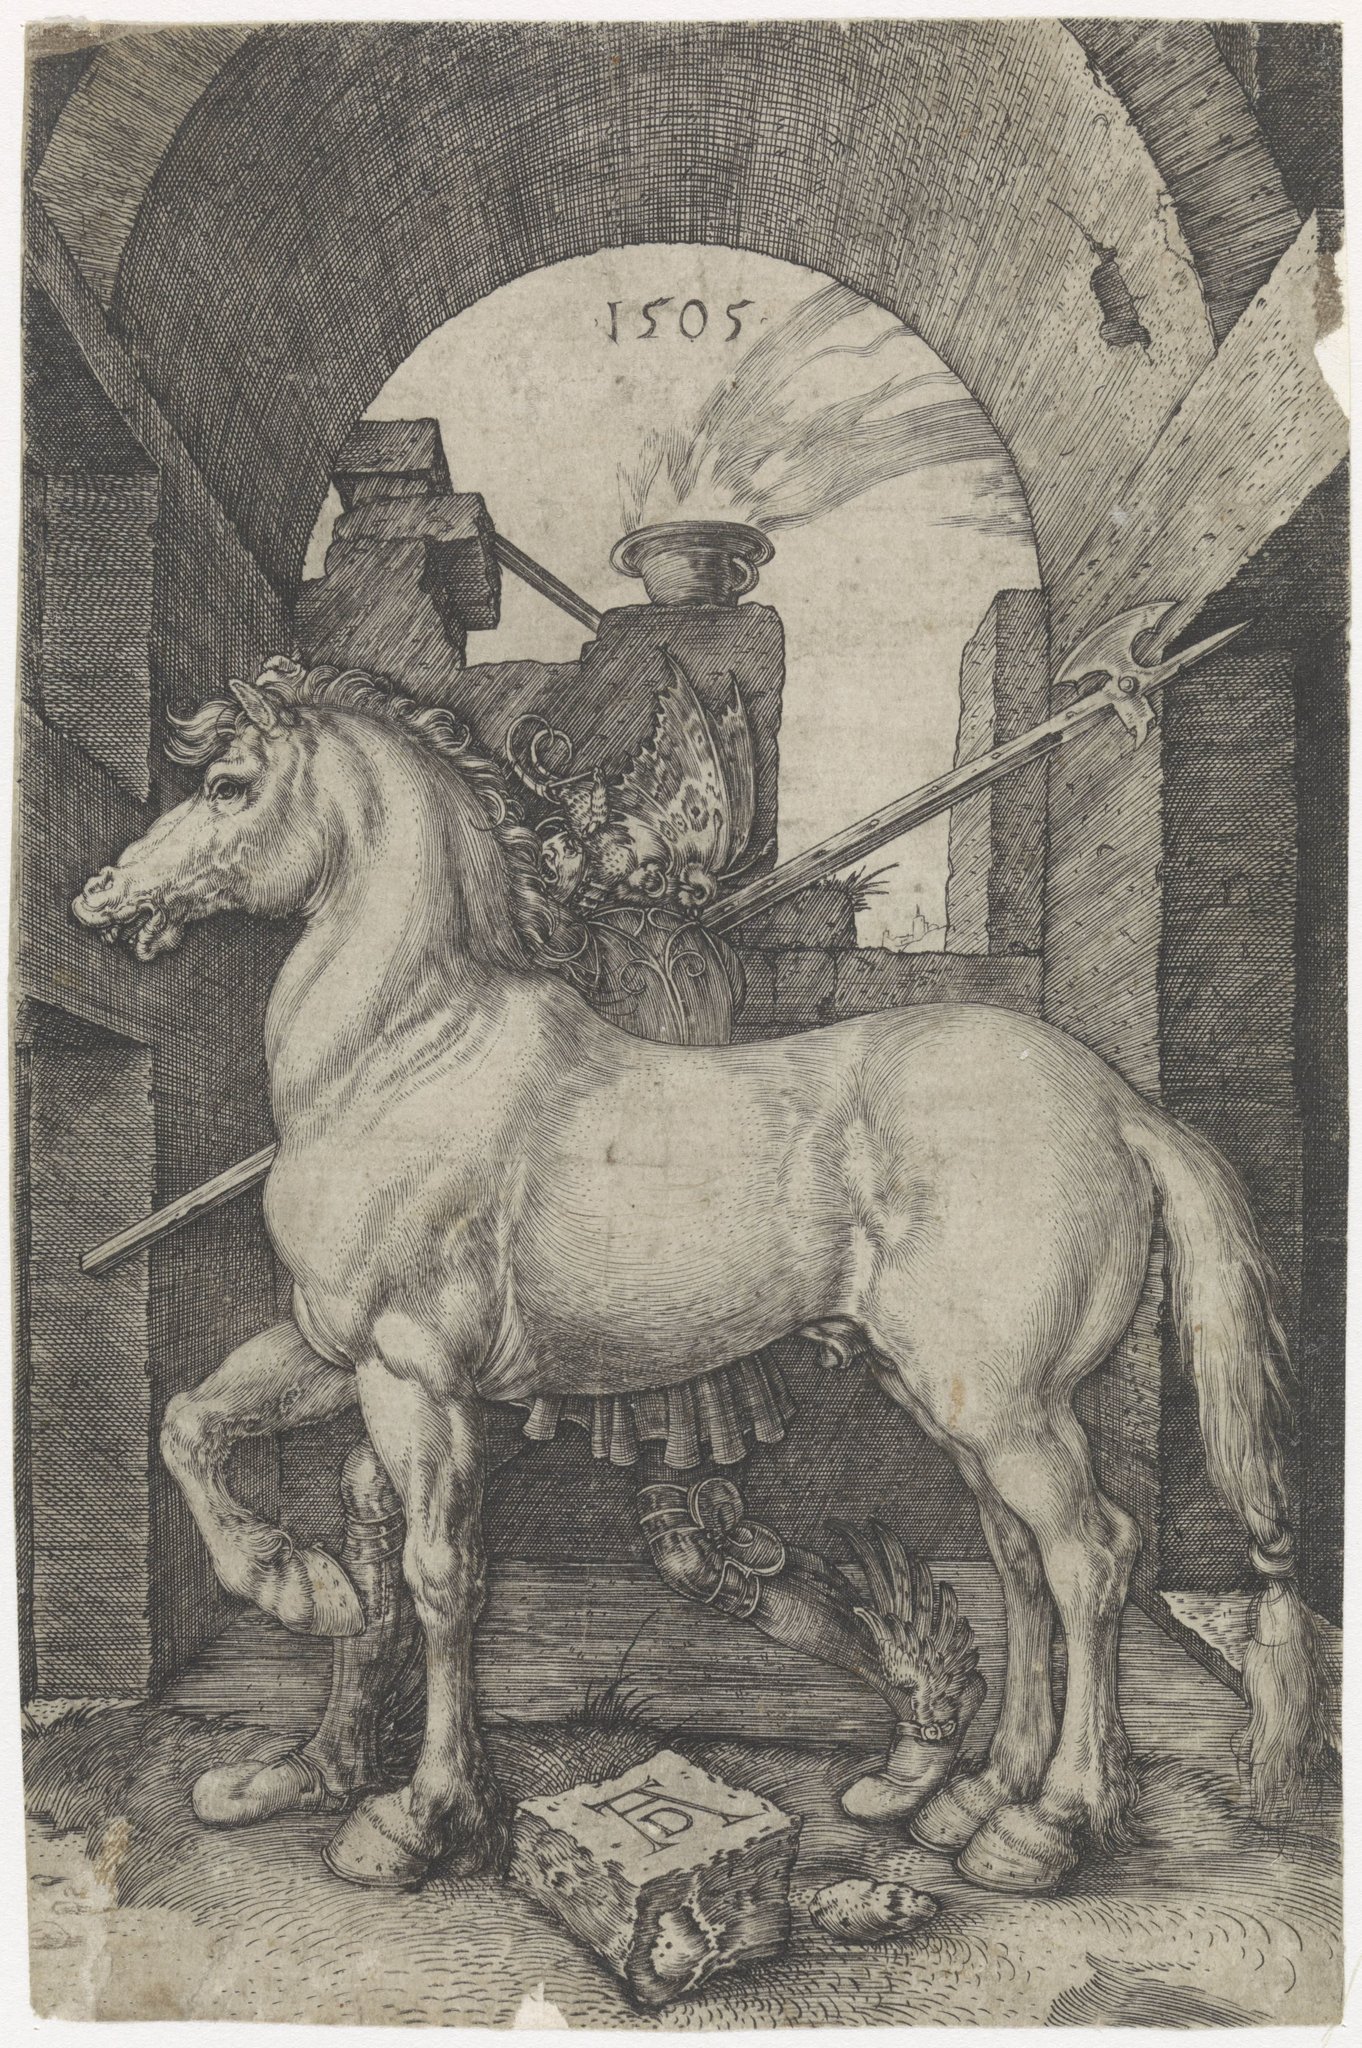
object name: print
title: Het kleine paard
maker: albrecht dürer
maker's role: draughtsman, painter, print maker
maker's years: 1471-1528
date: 1505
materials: paper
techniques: engraving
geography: nuremberg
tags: horse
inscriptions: collector's mark: Lugt 2228a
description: Een paard, staande in een vervallen gebouw, onder een tongewelf. Achter het dier loopt een man, gekleed als soldaat, bewapend met een hellebaard, een monsterlijk dier of hoofddeksel op zijn hoofd en gevleugelde schoenen aan zijn voeten. Op de achtergrond een pot waarin vuur brandt.